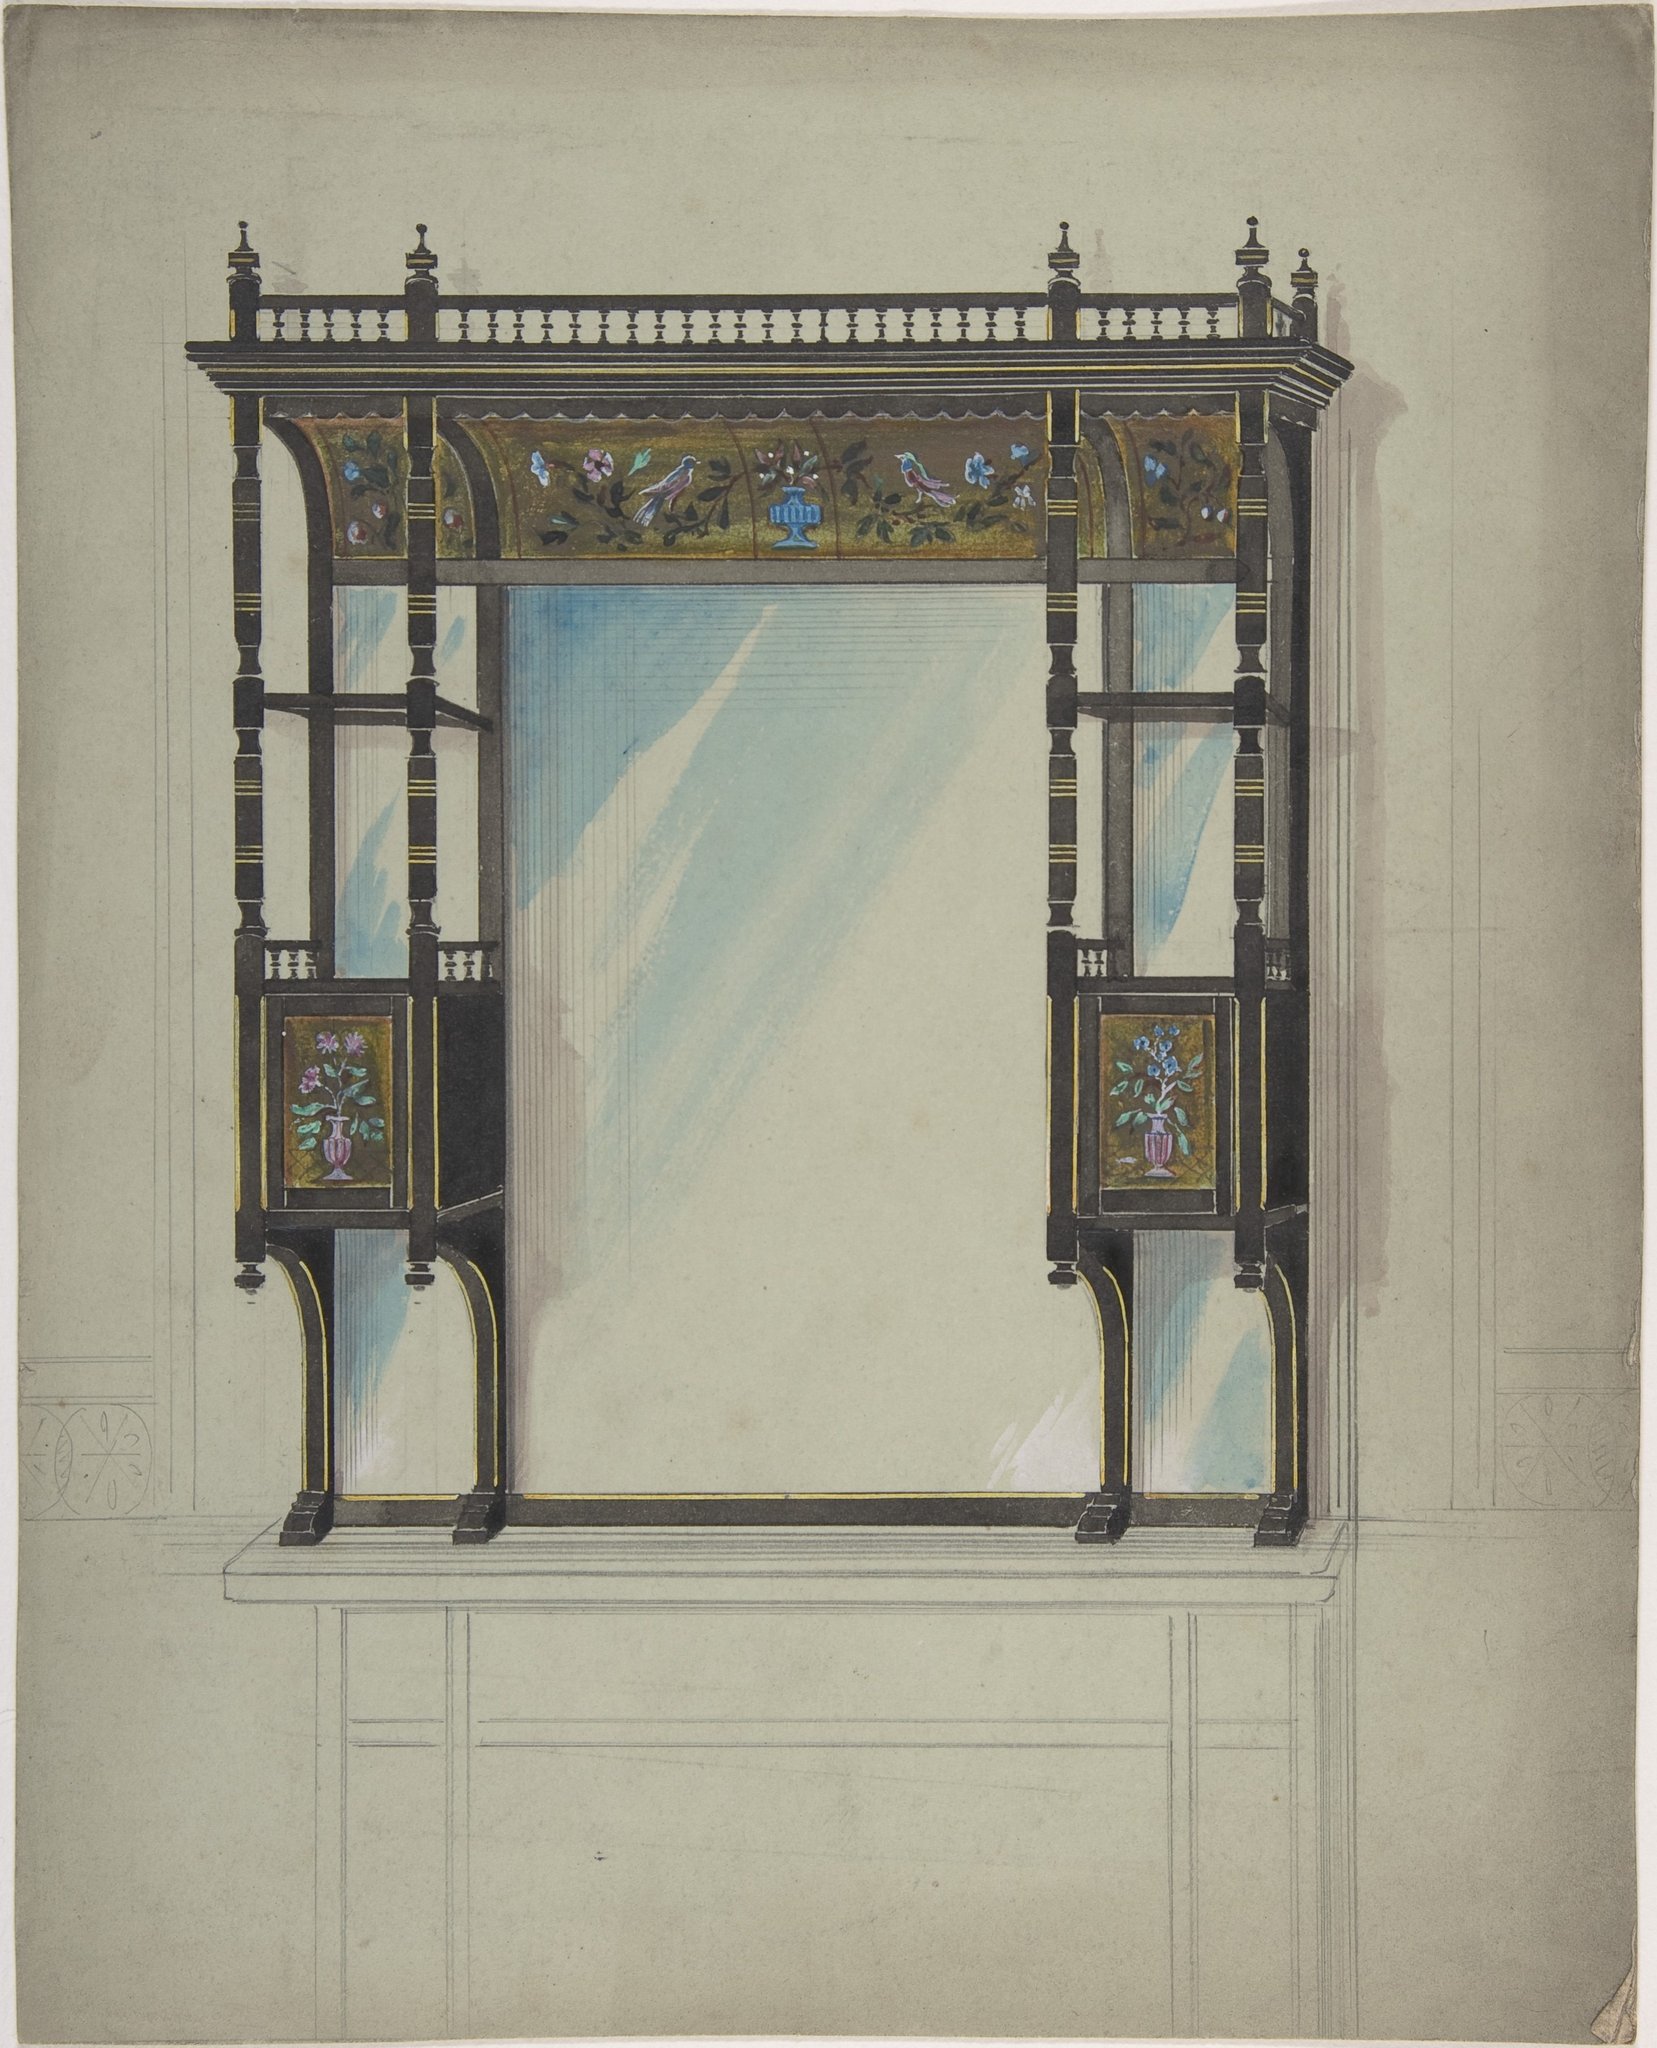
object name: drawing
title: Design for a Mirror over a Mantel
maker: anonymous, british, 19th century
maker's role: artist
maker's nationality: british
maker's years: 1800-1900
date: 1840-1899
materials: gouache, ink, watercolor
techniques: pen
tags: birds,flowers,mirrors